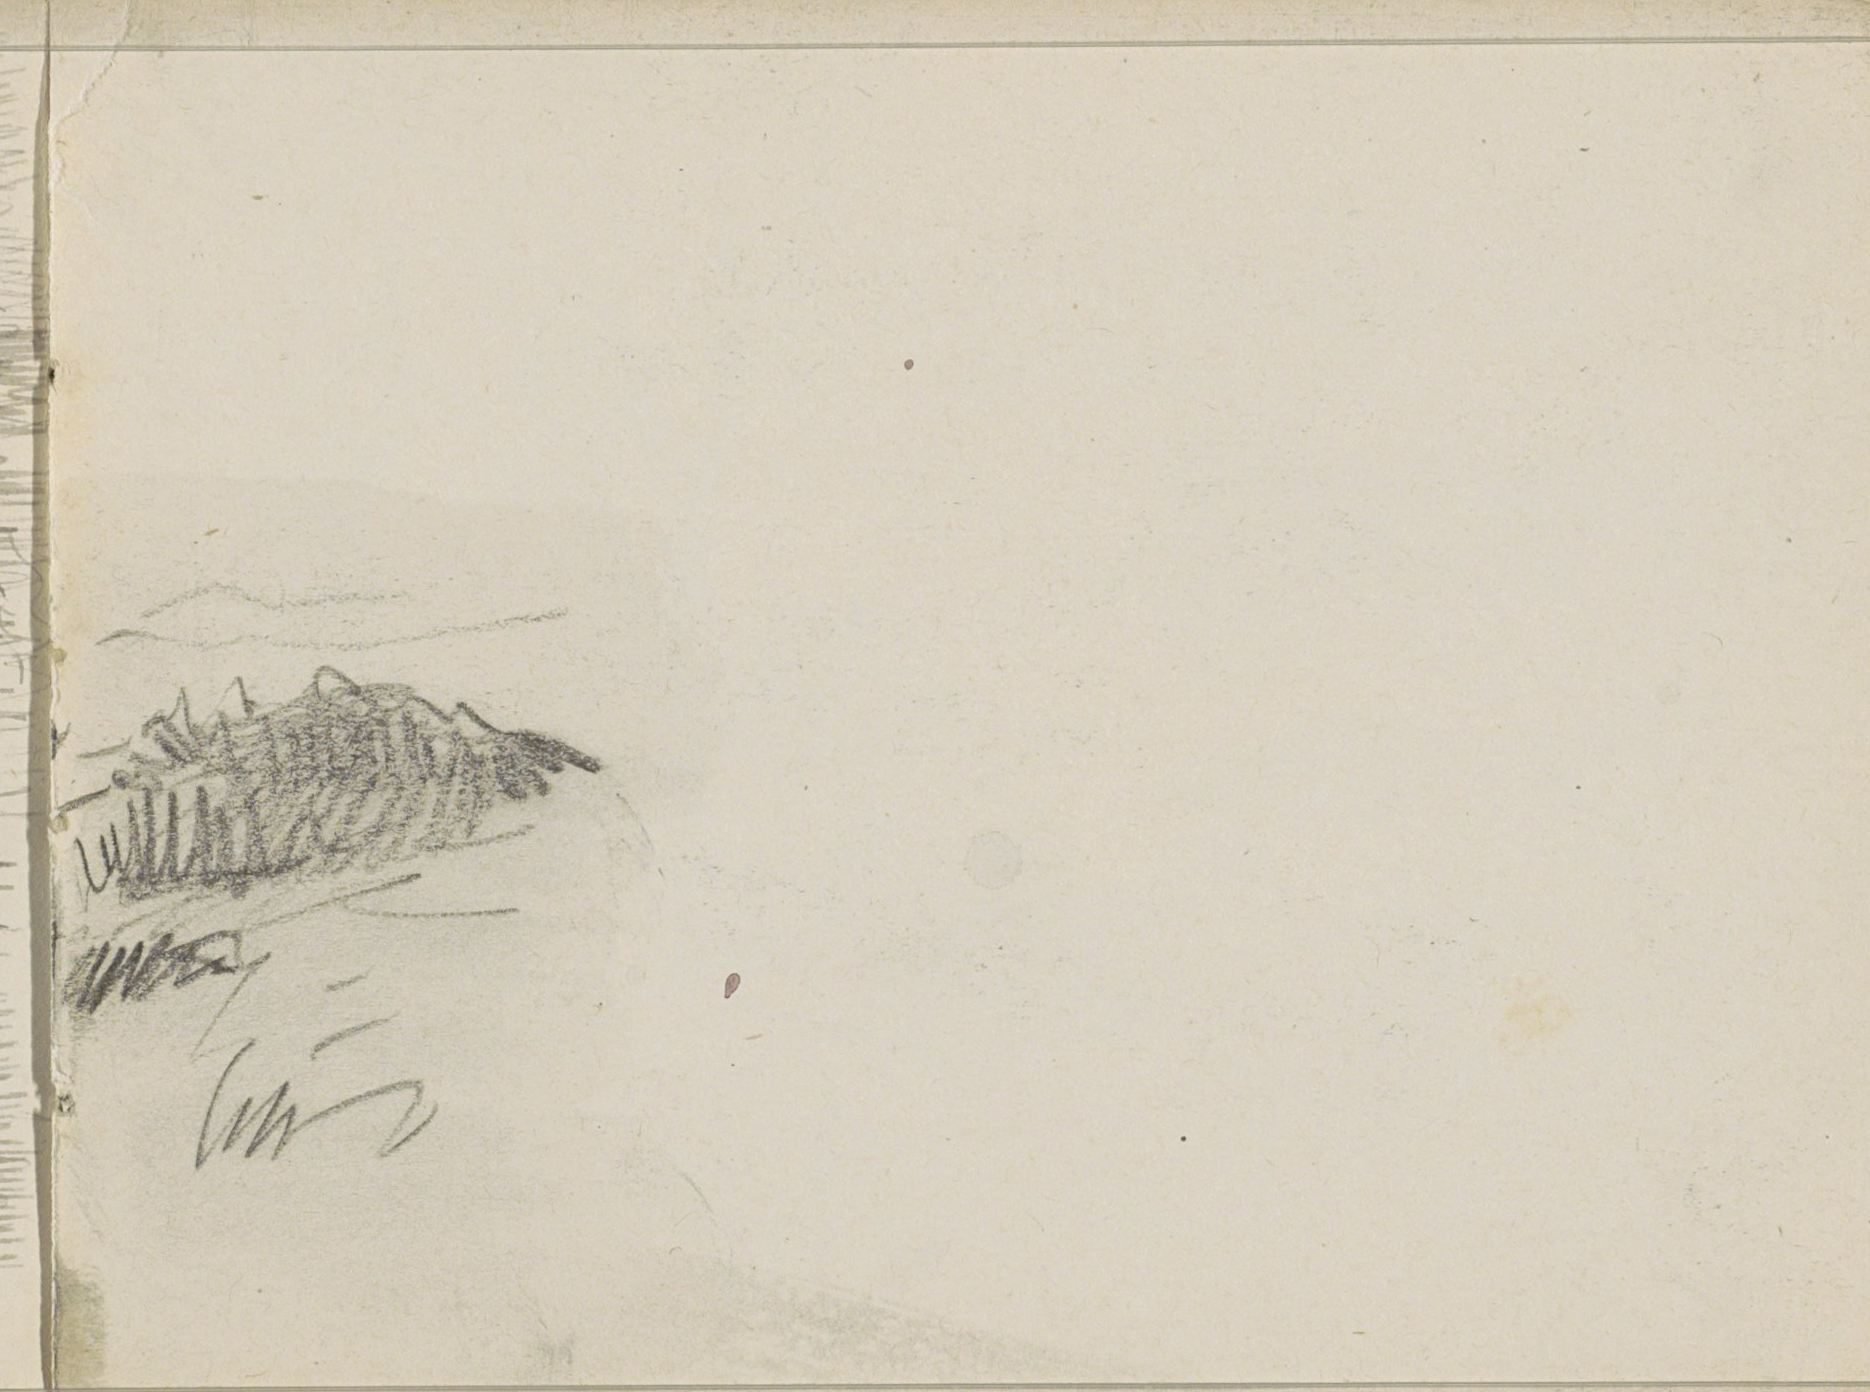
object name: sketchbook leaf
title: Vegetatie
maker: johan antonie de jonge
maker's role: draughtsman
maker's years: 1864-1927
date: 1884-1927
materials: chalk, paper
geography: south holland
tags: shrubs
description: De tekening is zeer waarschijnlijk niet oorspronkelijk op deze plaats in het schetsboek bevestigd geweest.